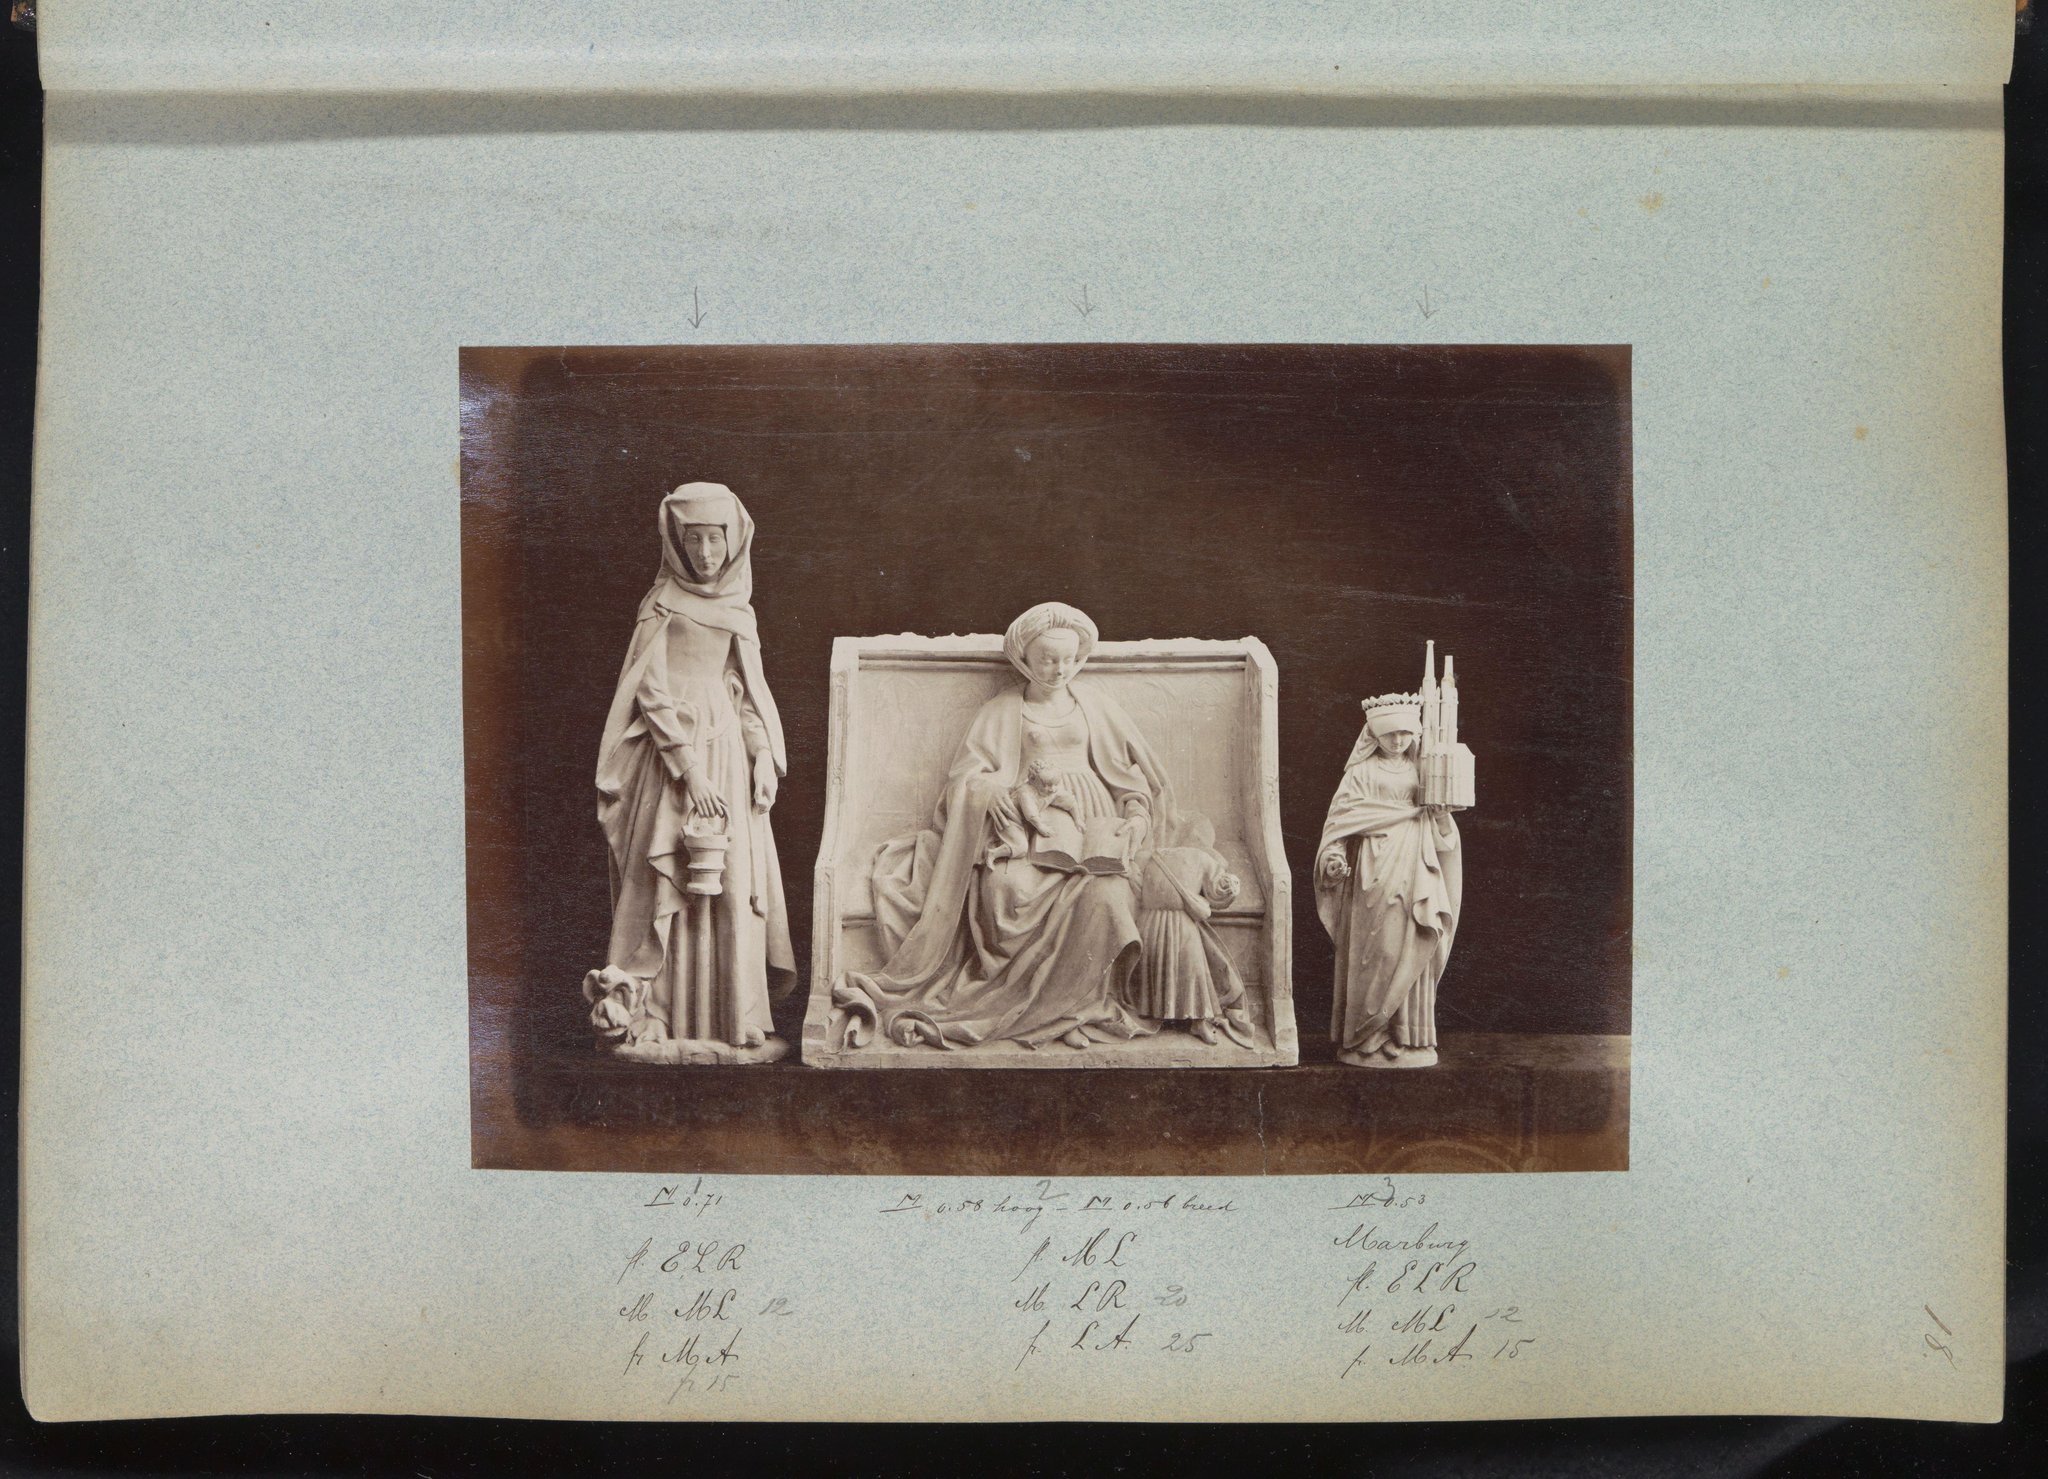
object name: album leaf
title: Drie gipsen afgietsels van sculpturen, vermoedelijk uit een kerk te Marburg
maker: Anonymous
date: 1875-1900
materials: paper, photographic support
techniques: albumen print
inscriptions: annotation: ‘M 0.71 M 0.58 hoog M 0.56 breed M 0.53’, annotation